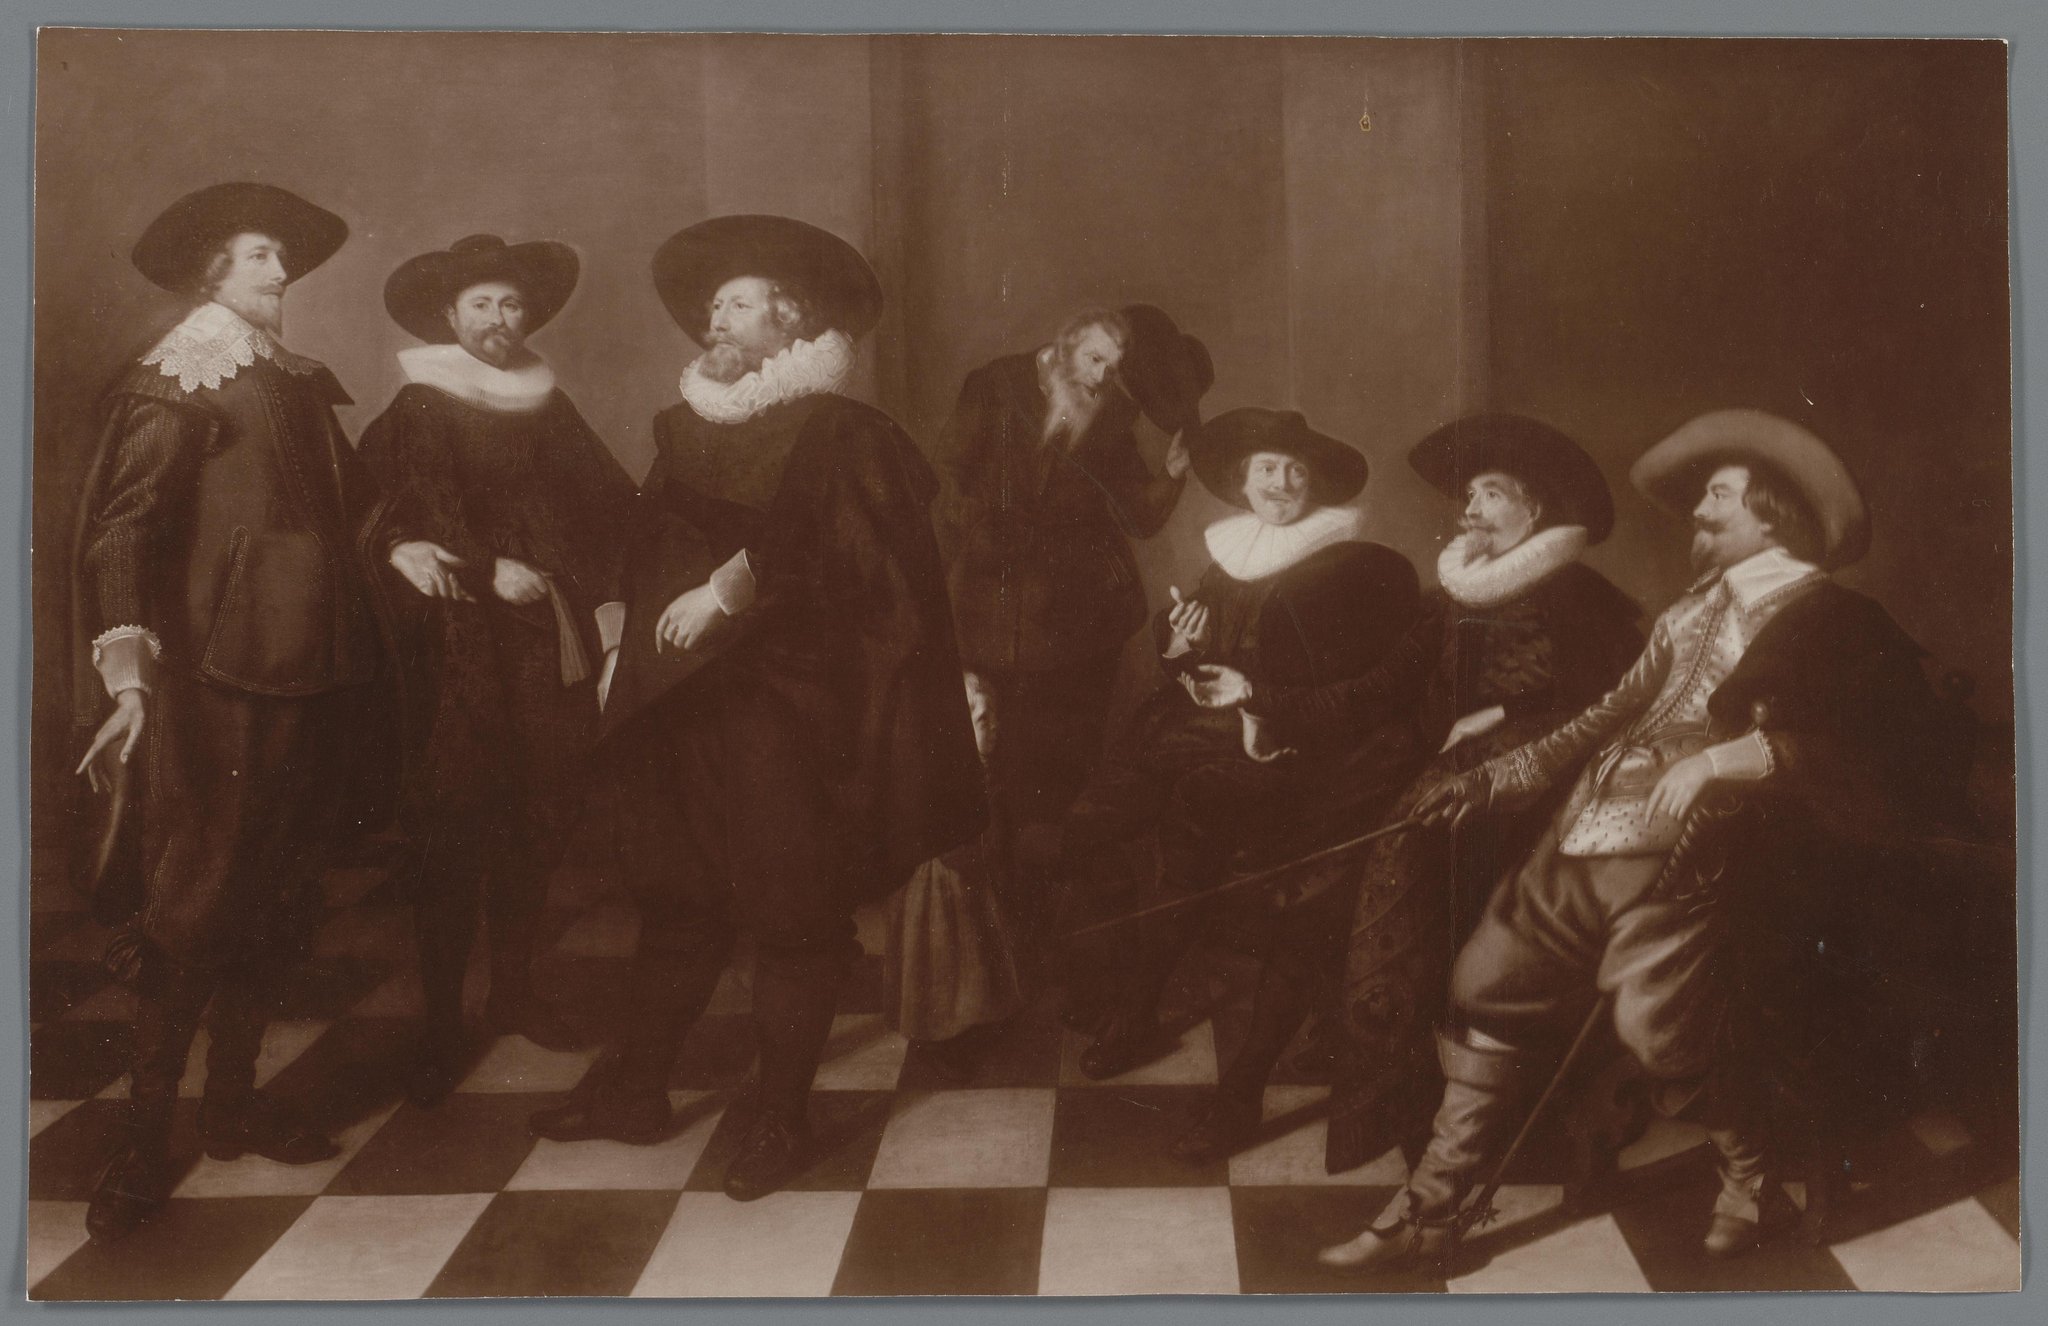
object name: reproduction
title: Fotoreproductie van schilderij van Regenten van een weeshuis in Amsterdam, door Abraham de Vries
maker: Anonymous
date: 1890-1920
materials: paper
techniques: gelatin silver print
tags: board, esp. governors, trustees, etc. (dutch: 'regenten')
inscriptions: number: ‘555.’